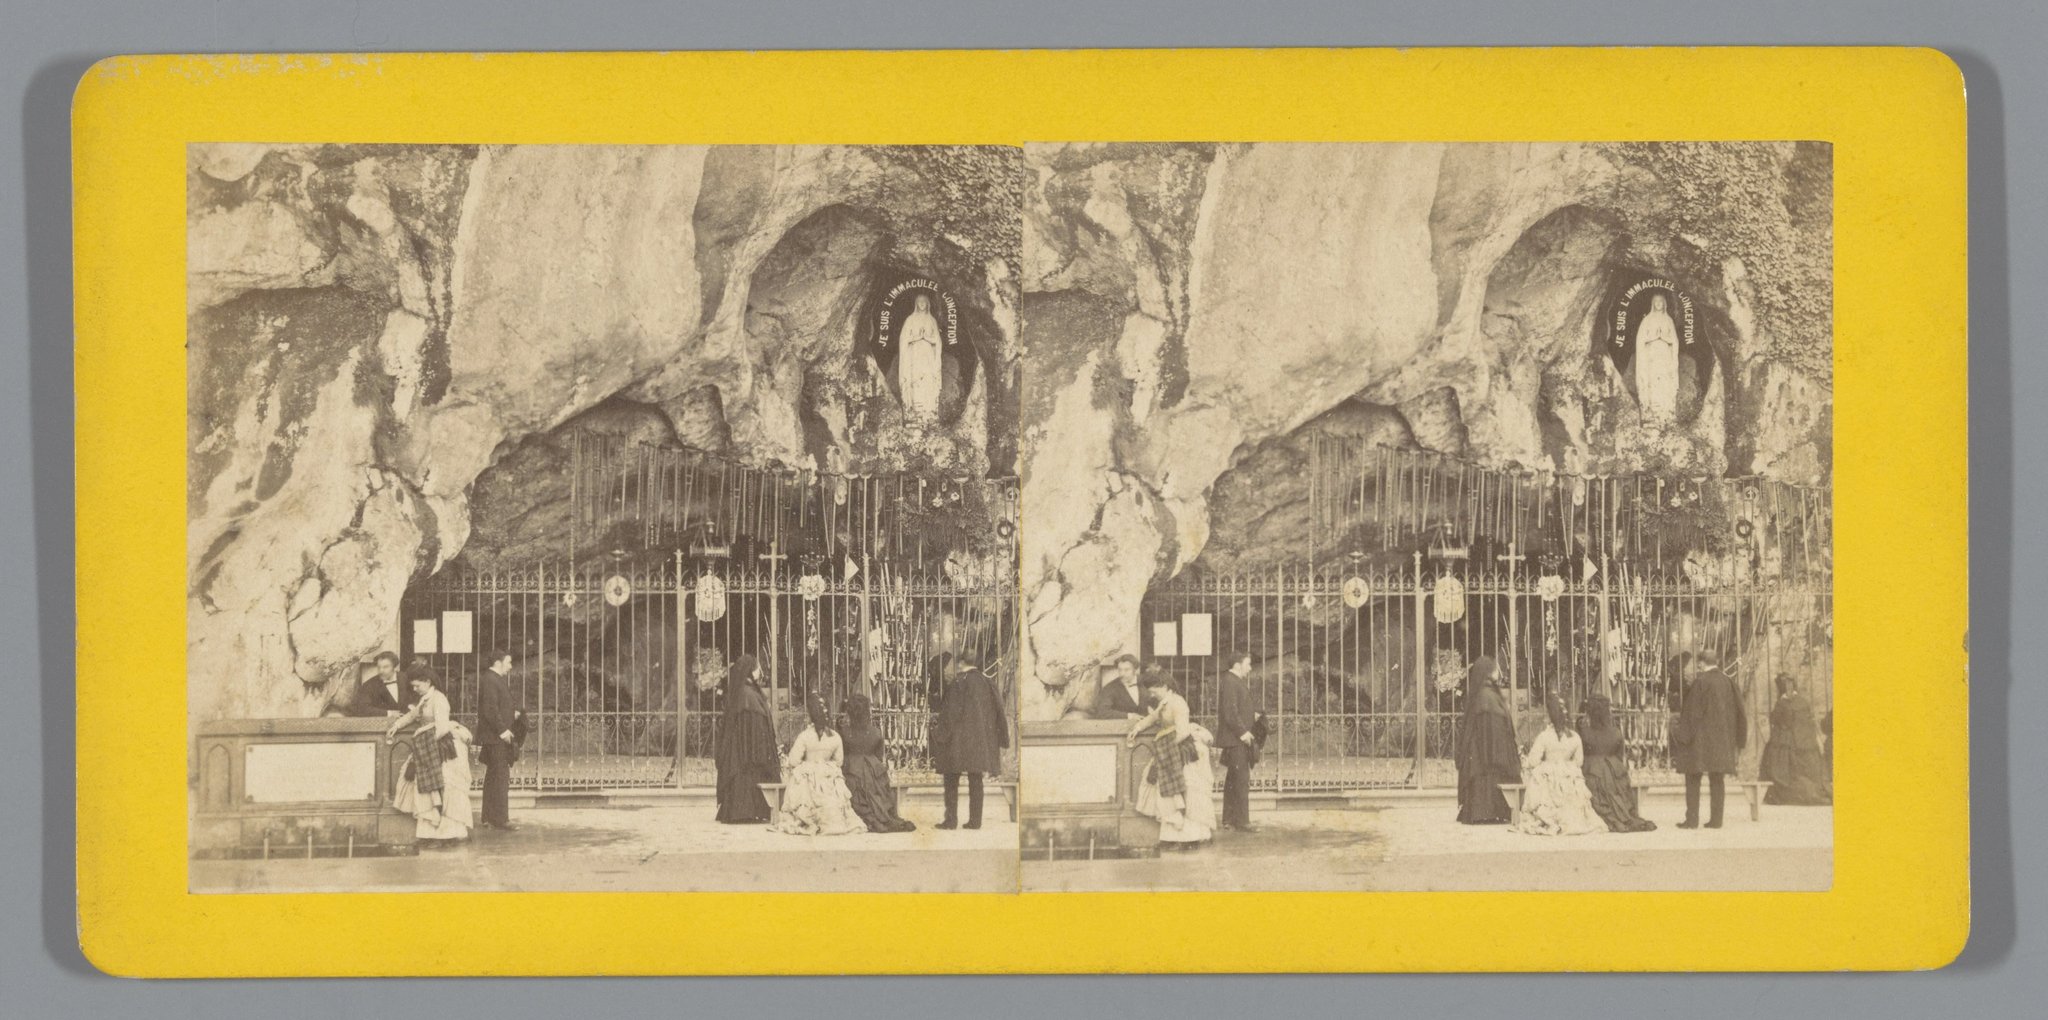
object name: stereograph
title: Grot van Massabielle te Lourdes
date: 1860-1880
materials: cardboard, photographic support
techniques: albumen print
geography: lourdes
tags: parts of church exterior and annexes: chapel, cave, grotto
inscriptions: inscription: ‘Provost photographes 23, Rue Lafayette Toulouse (...) No.’